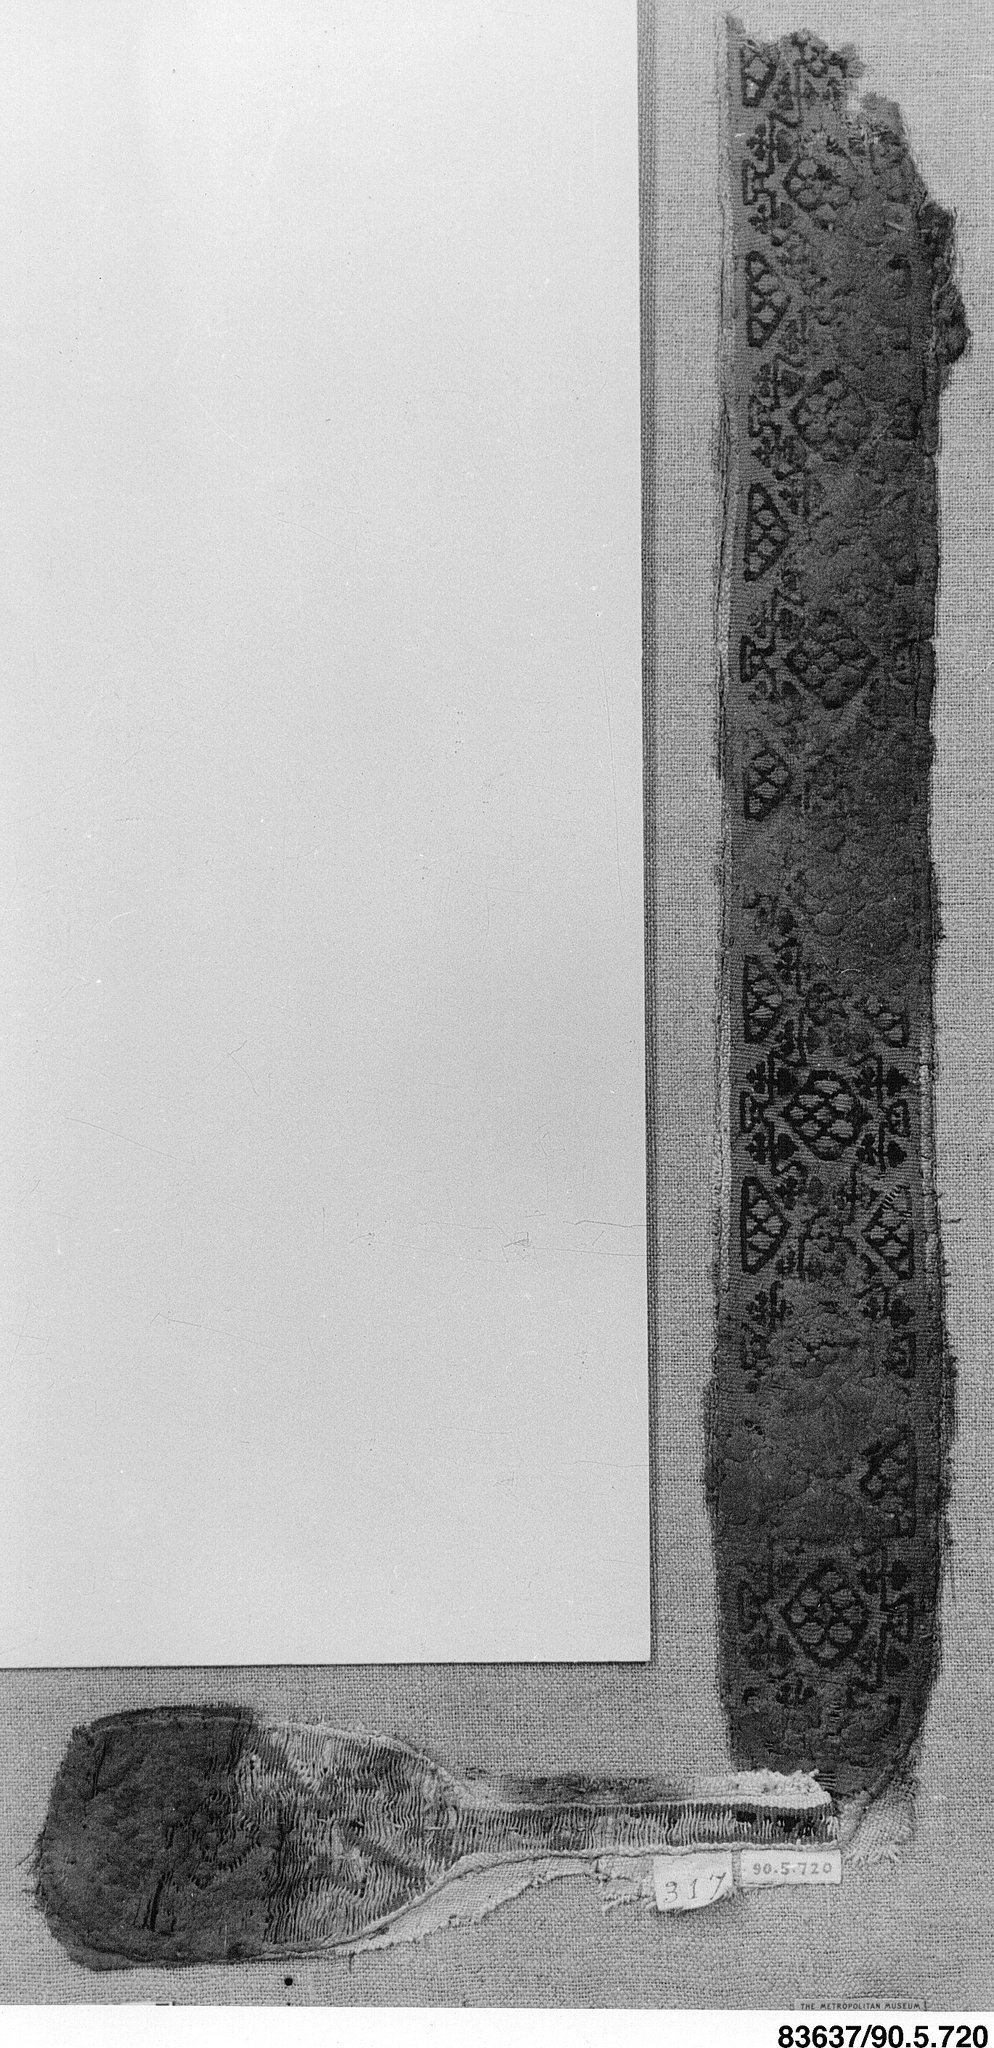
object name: textile fragment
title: Fragment of Shoulder Band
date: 401-600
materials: linen, wool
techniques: weave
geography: egypt